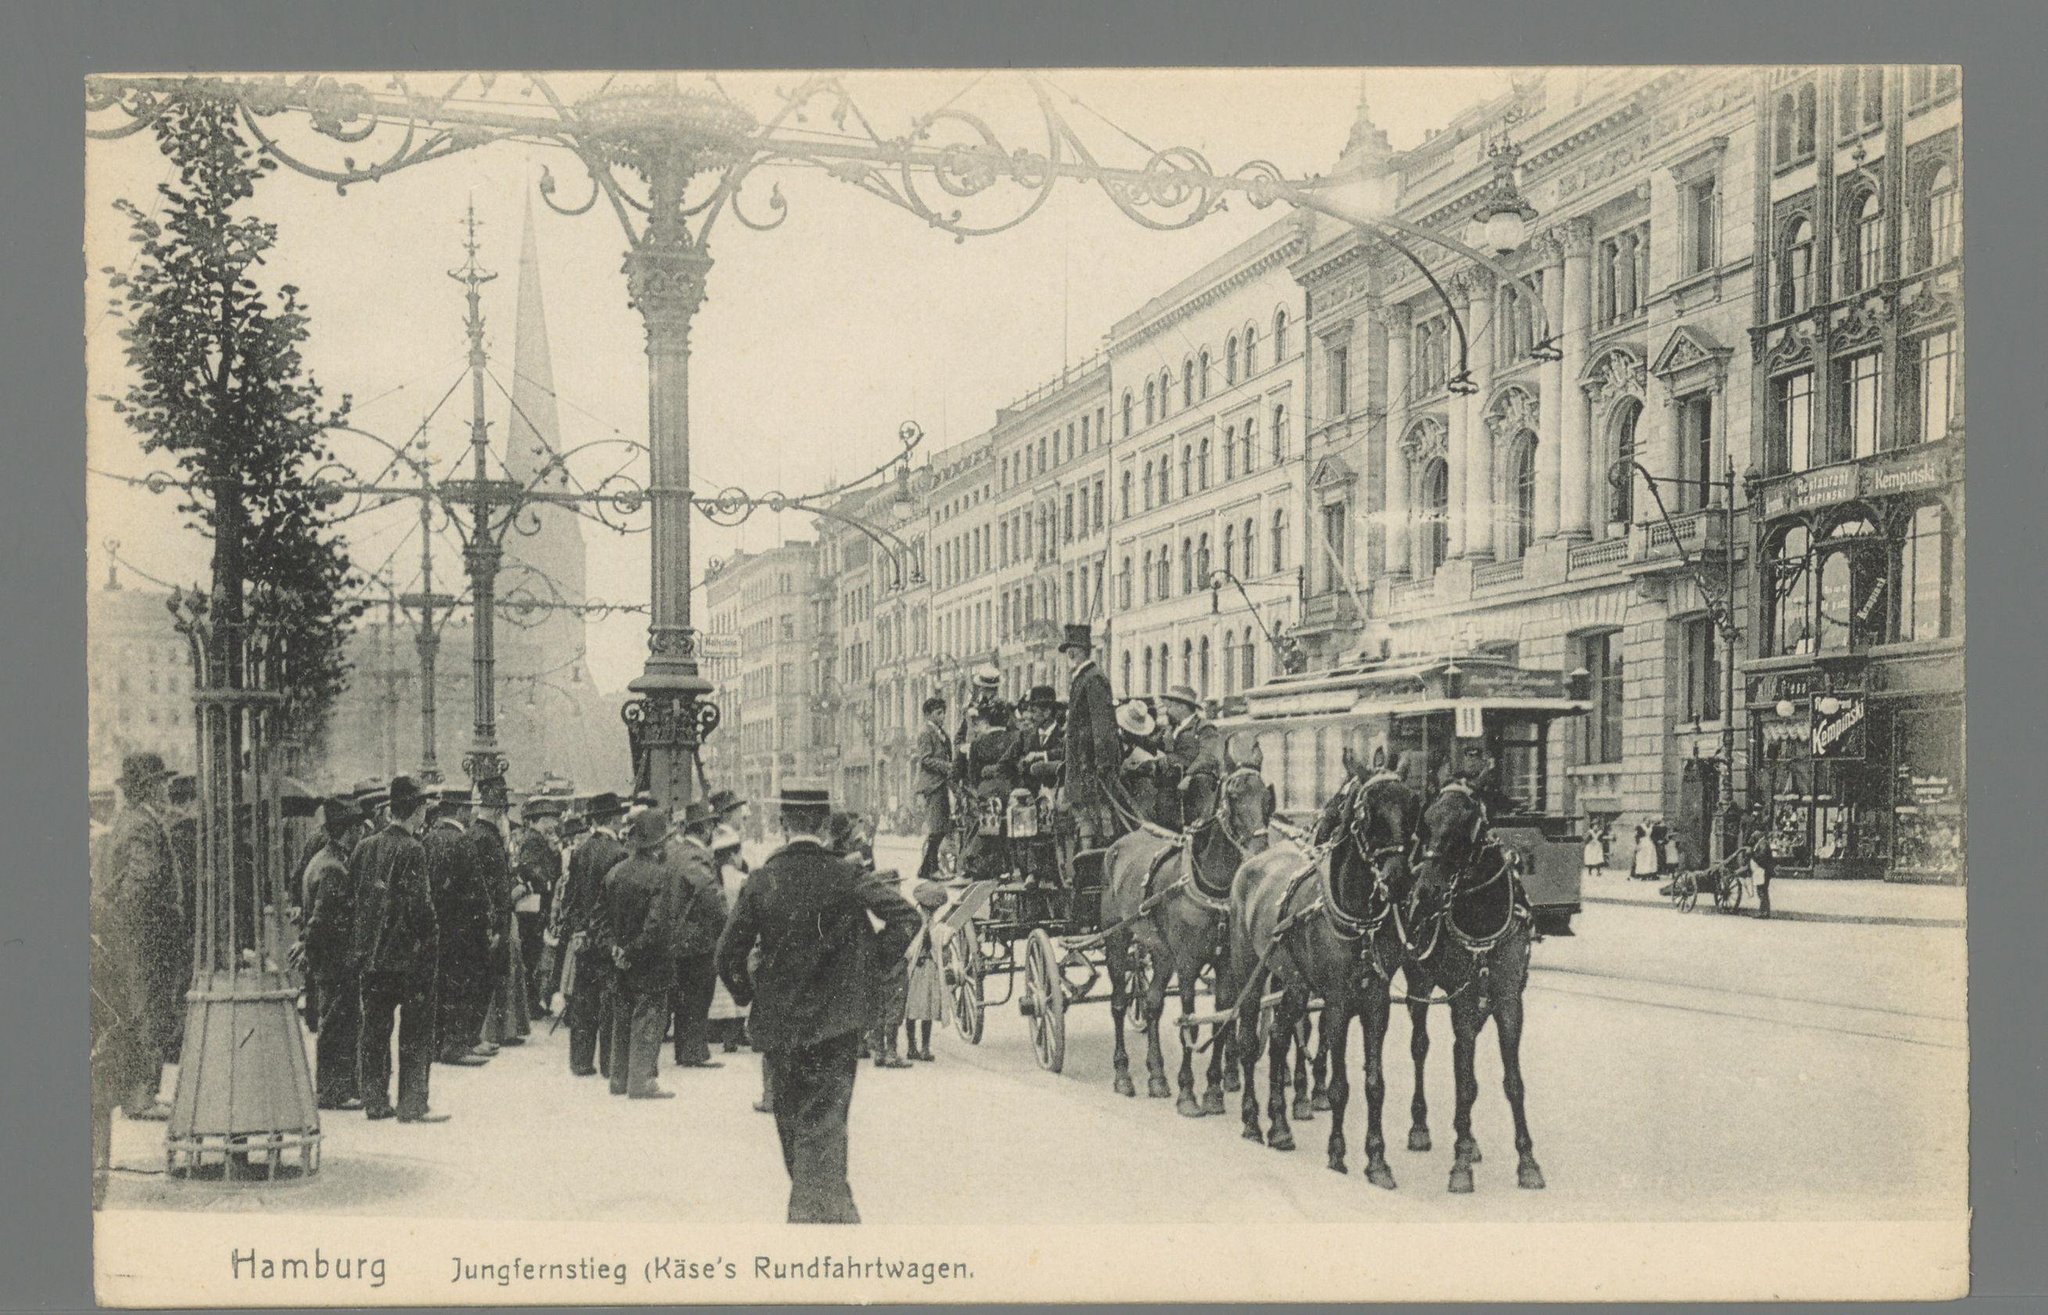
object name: ansichtkaart, prentbriefkaart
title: Hamburg. Jungfernstieg (Käse's Rundfahrtwagen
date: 1906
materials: cardboard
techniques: photograph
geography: hamburg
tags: diligence, omnibus, horse-tram, street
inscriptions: date